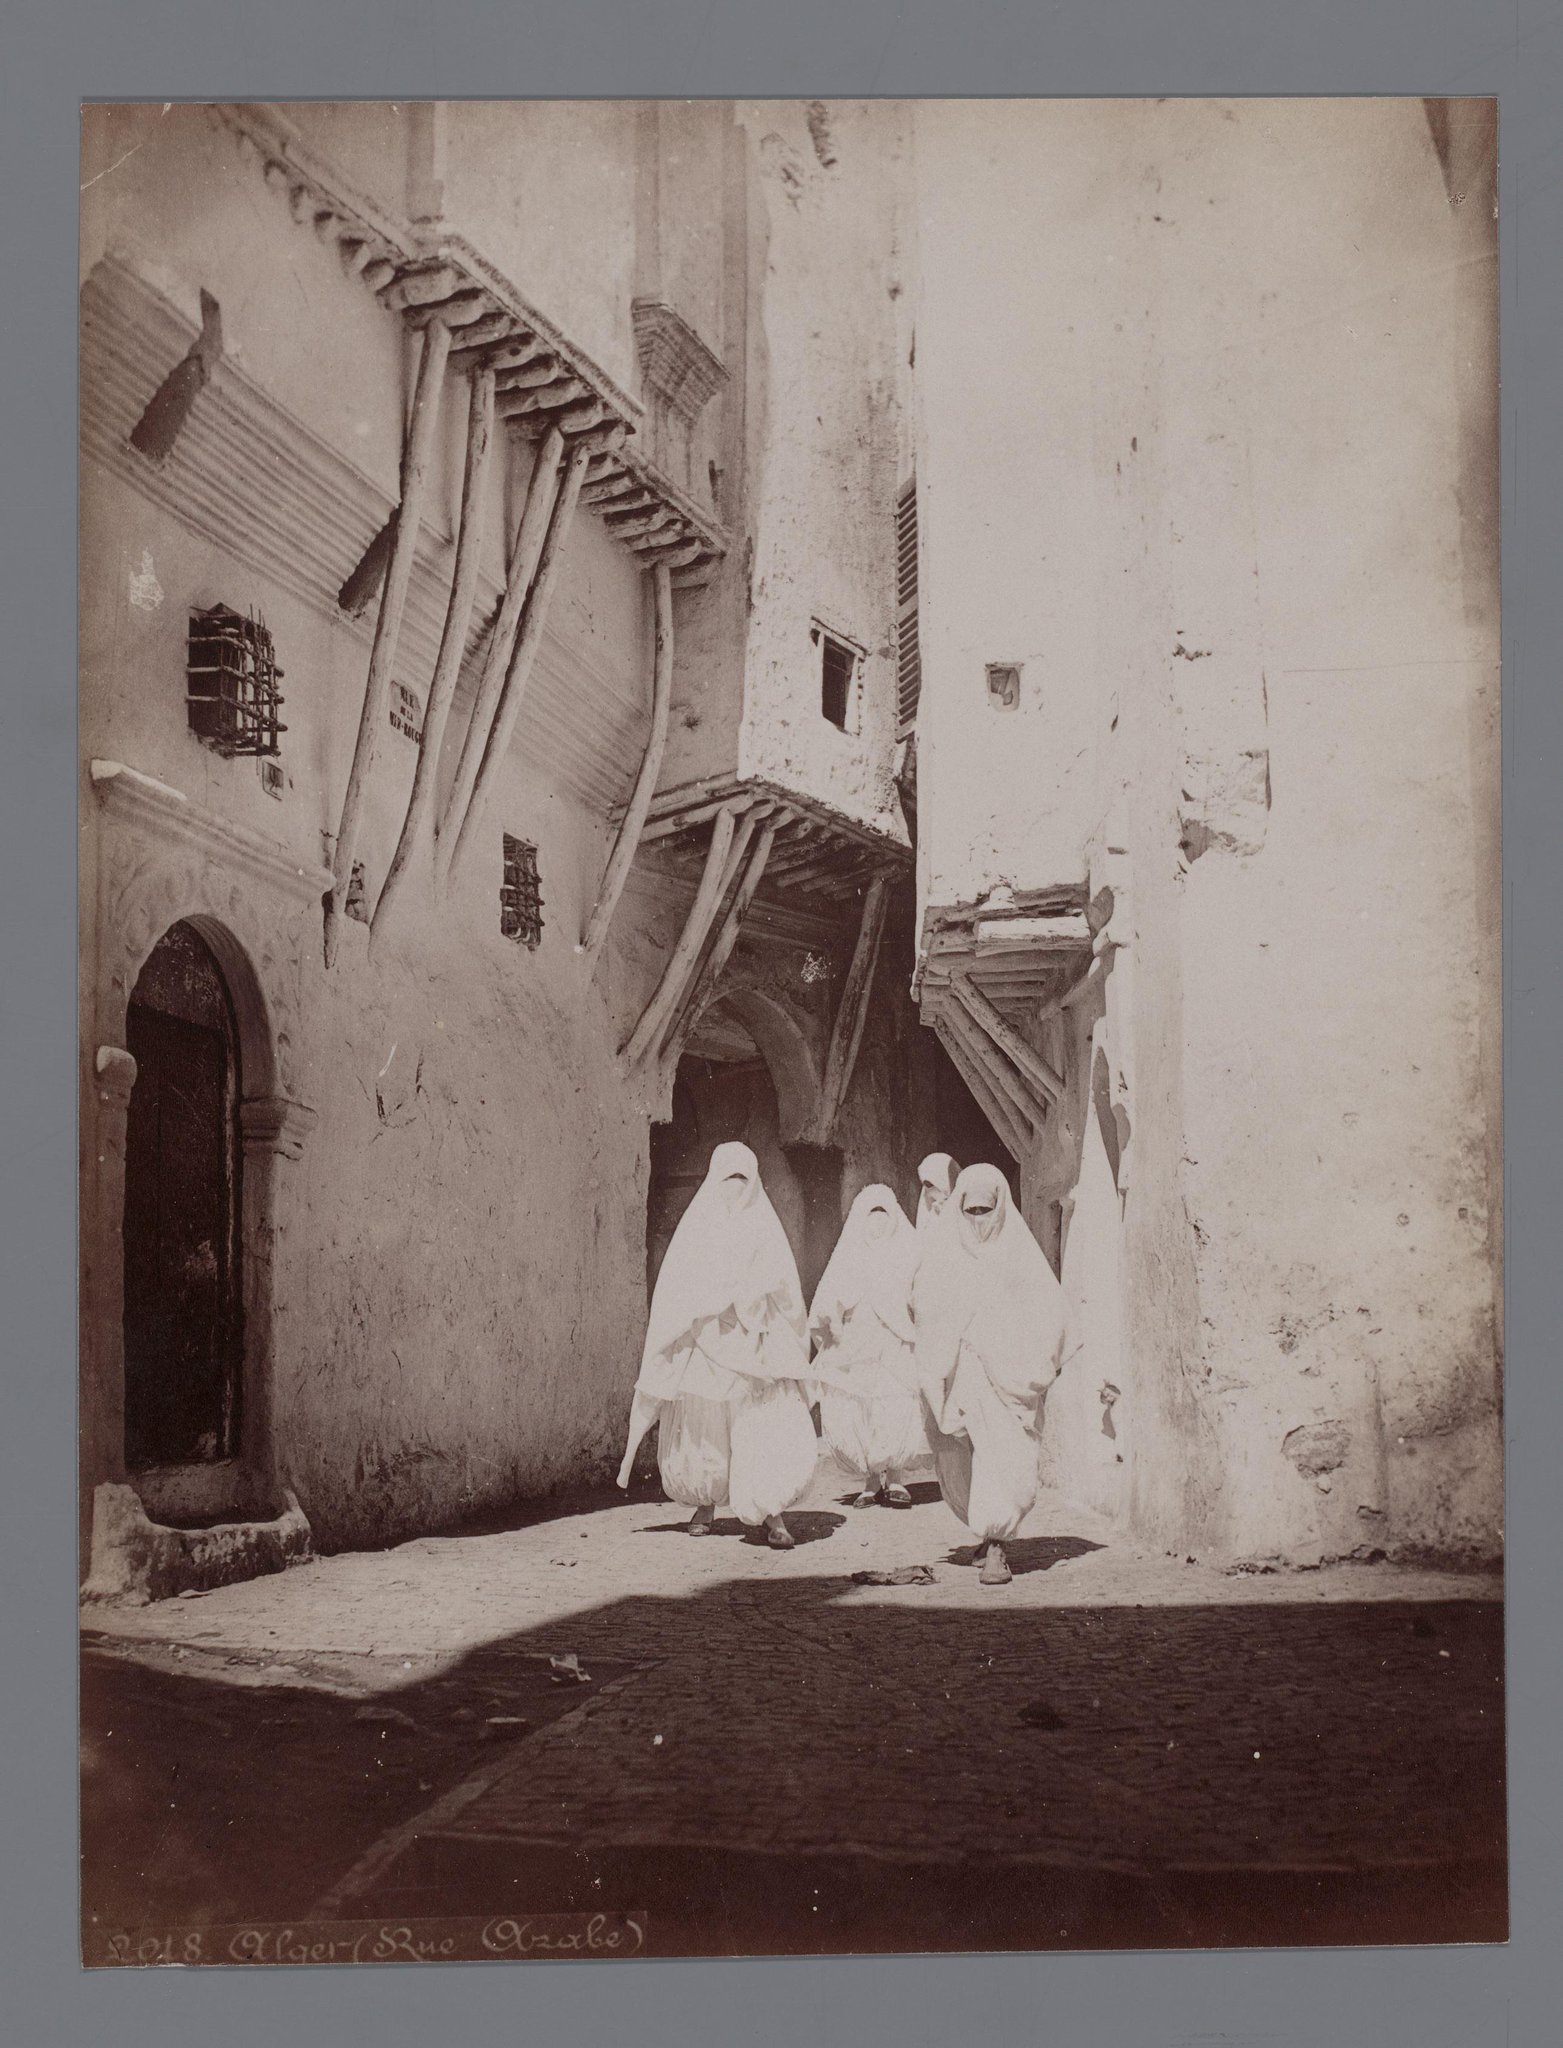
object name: photograph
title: Alger (Rue Arabe)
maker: Anonymous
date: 1860-1900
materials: paper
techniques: albumen print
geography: algiers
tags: adult woman, street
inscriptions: number: ‘2018.’